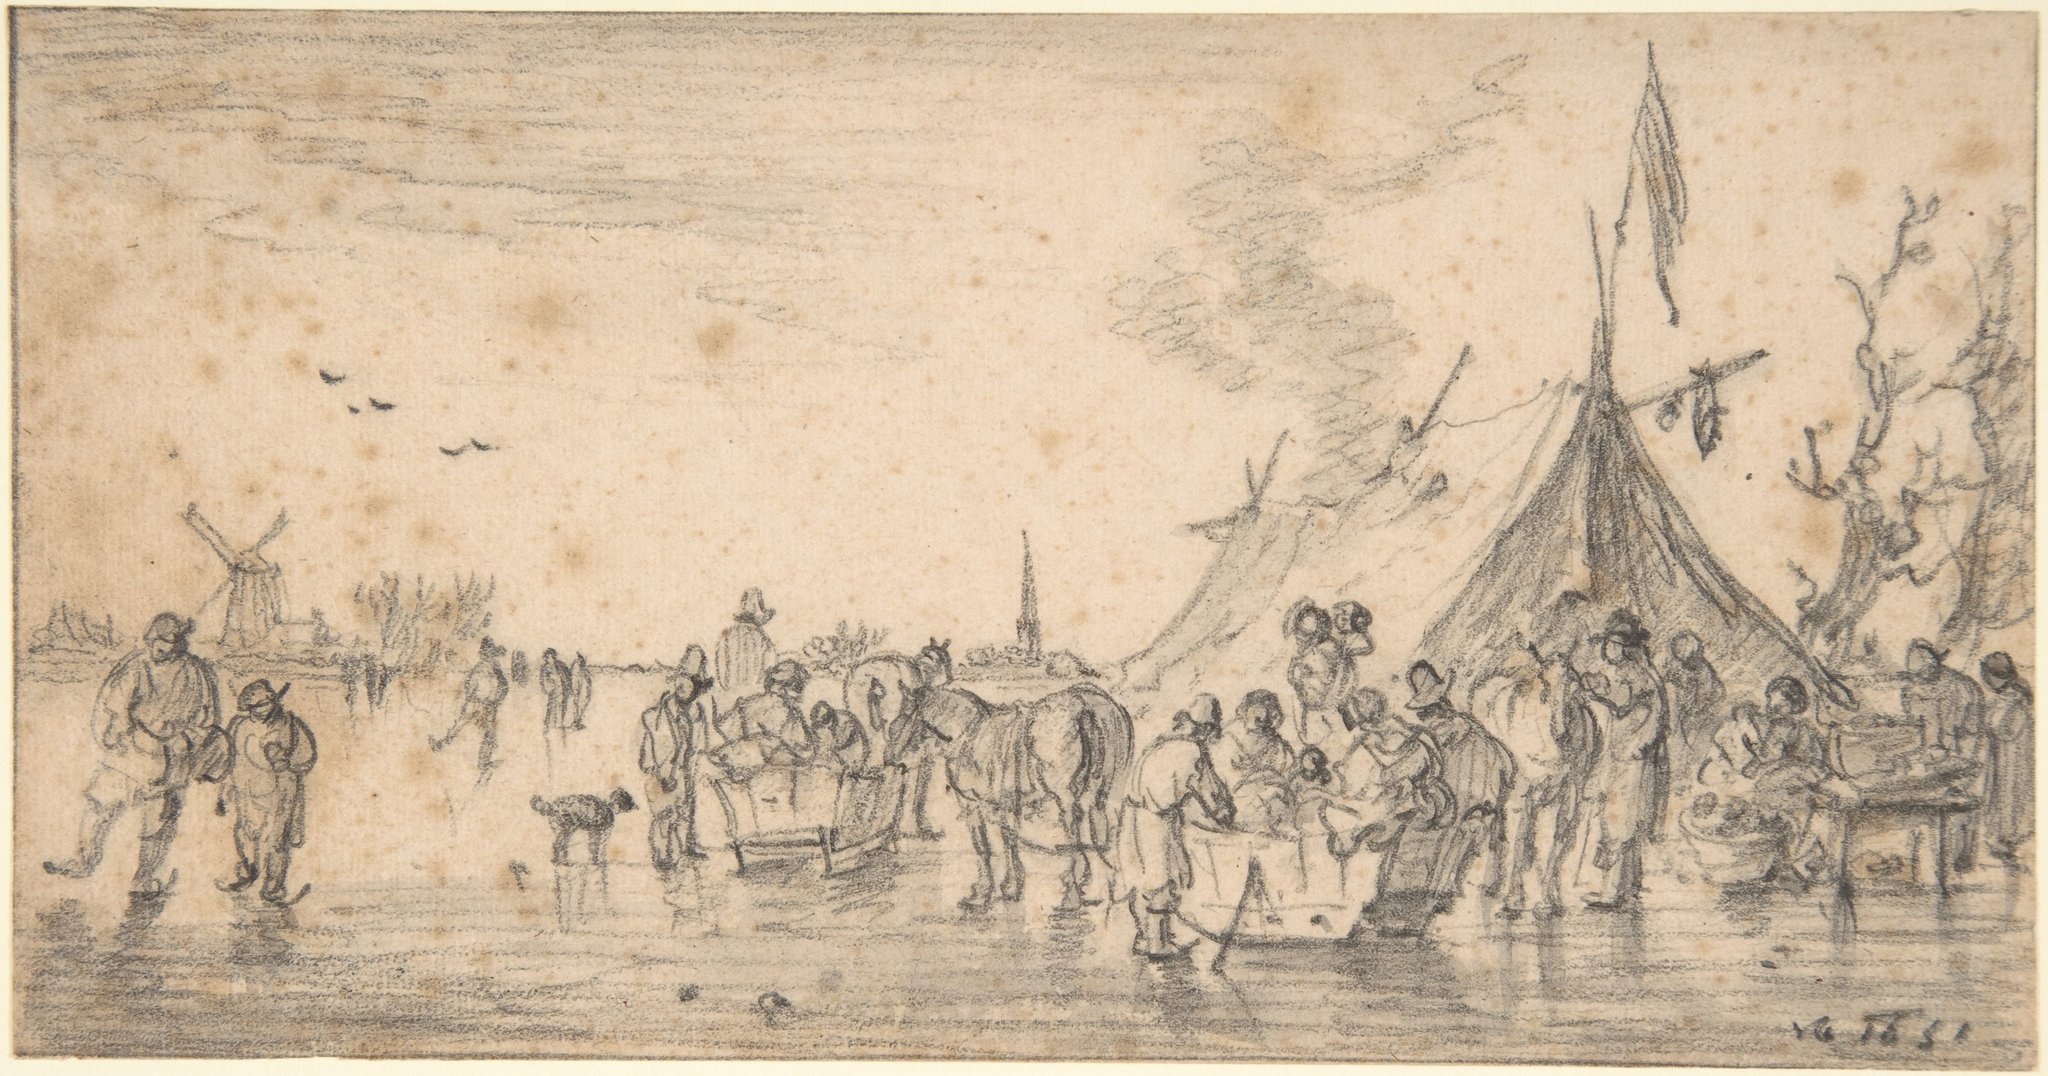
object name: drawing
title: River Landscape in Winter with Figures Skating and Sleds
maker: jan van goyen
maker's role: artist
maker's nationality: dutch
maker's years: 1596-1656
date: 1651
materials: chalk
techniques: wash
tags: skating,rivers,landscapes,winter,boats